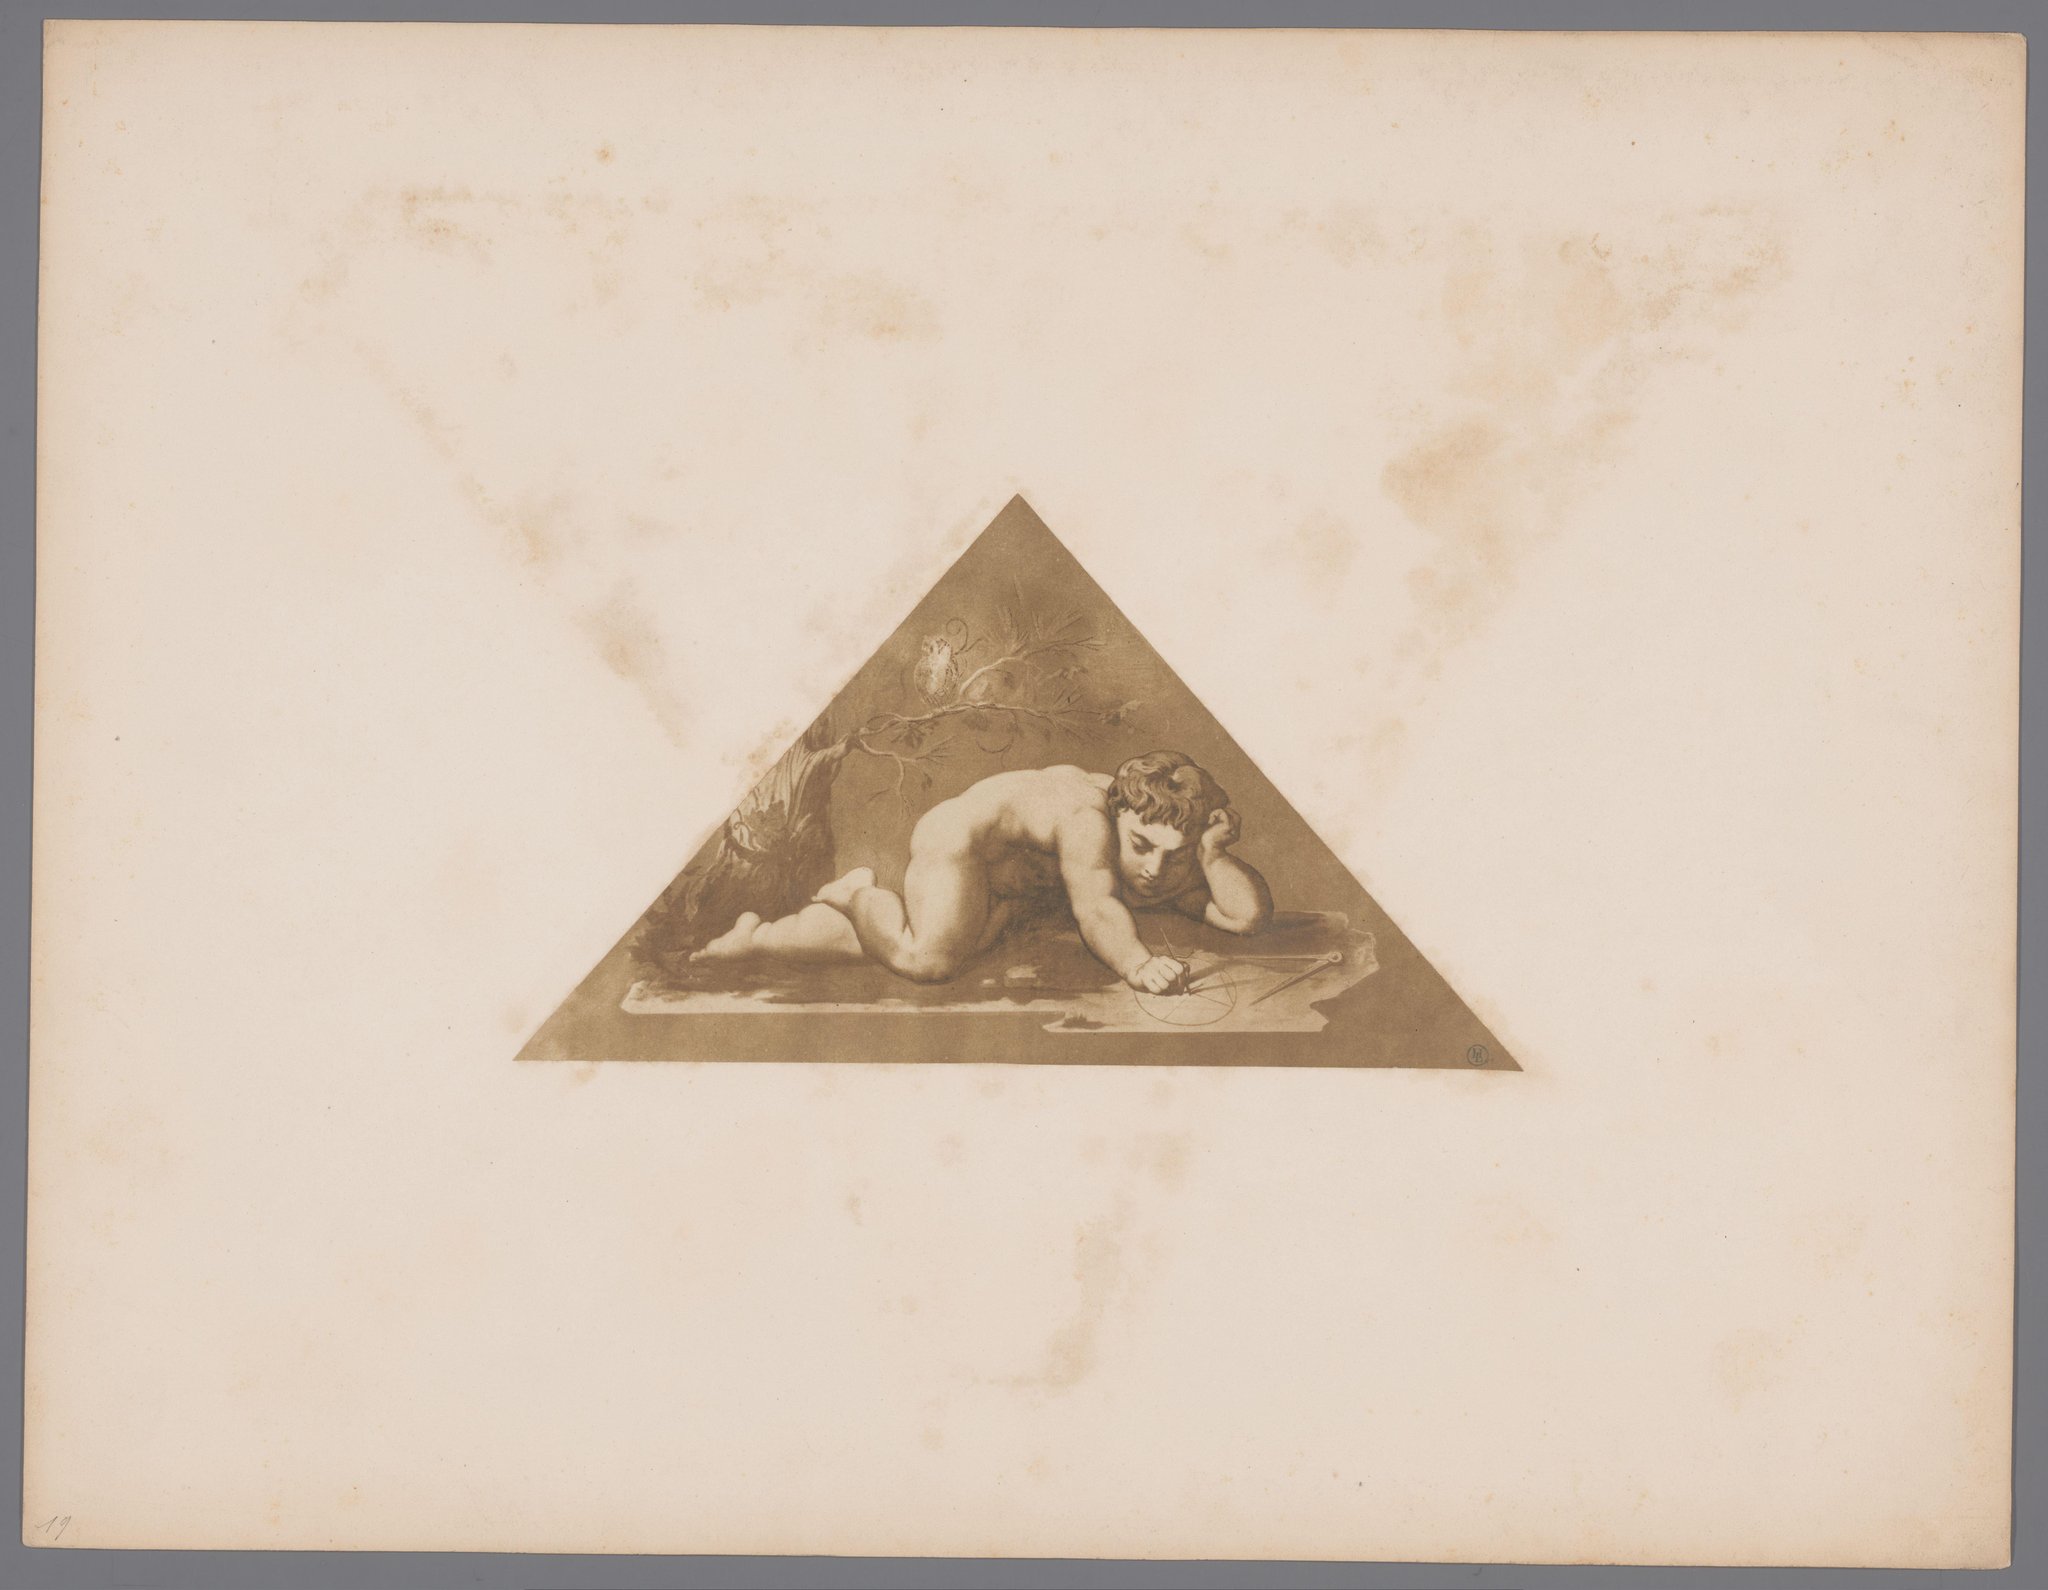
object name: photograph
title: Fotografische reproductie van decoratie aan plafond, Hotel de Ville, Parijs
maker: gustave le gray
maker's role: fotograaf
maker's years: 1820-1884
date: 1852-1853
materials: cardboard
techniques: salted paper print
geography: paris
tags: paris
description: Maakt onderdeel uit van een serie van 18 bladen met foto's van de cartons voor de plafondschilderingen door Henri Lehmann voor de Galerie des Fêtes in het Hotel de Ville, Parijs.